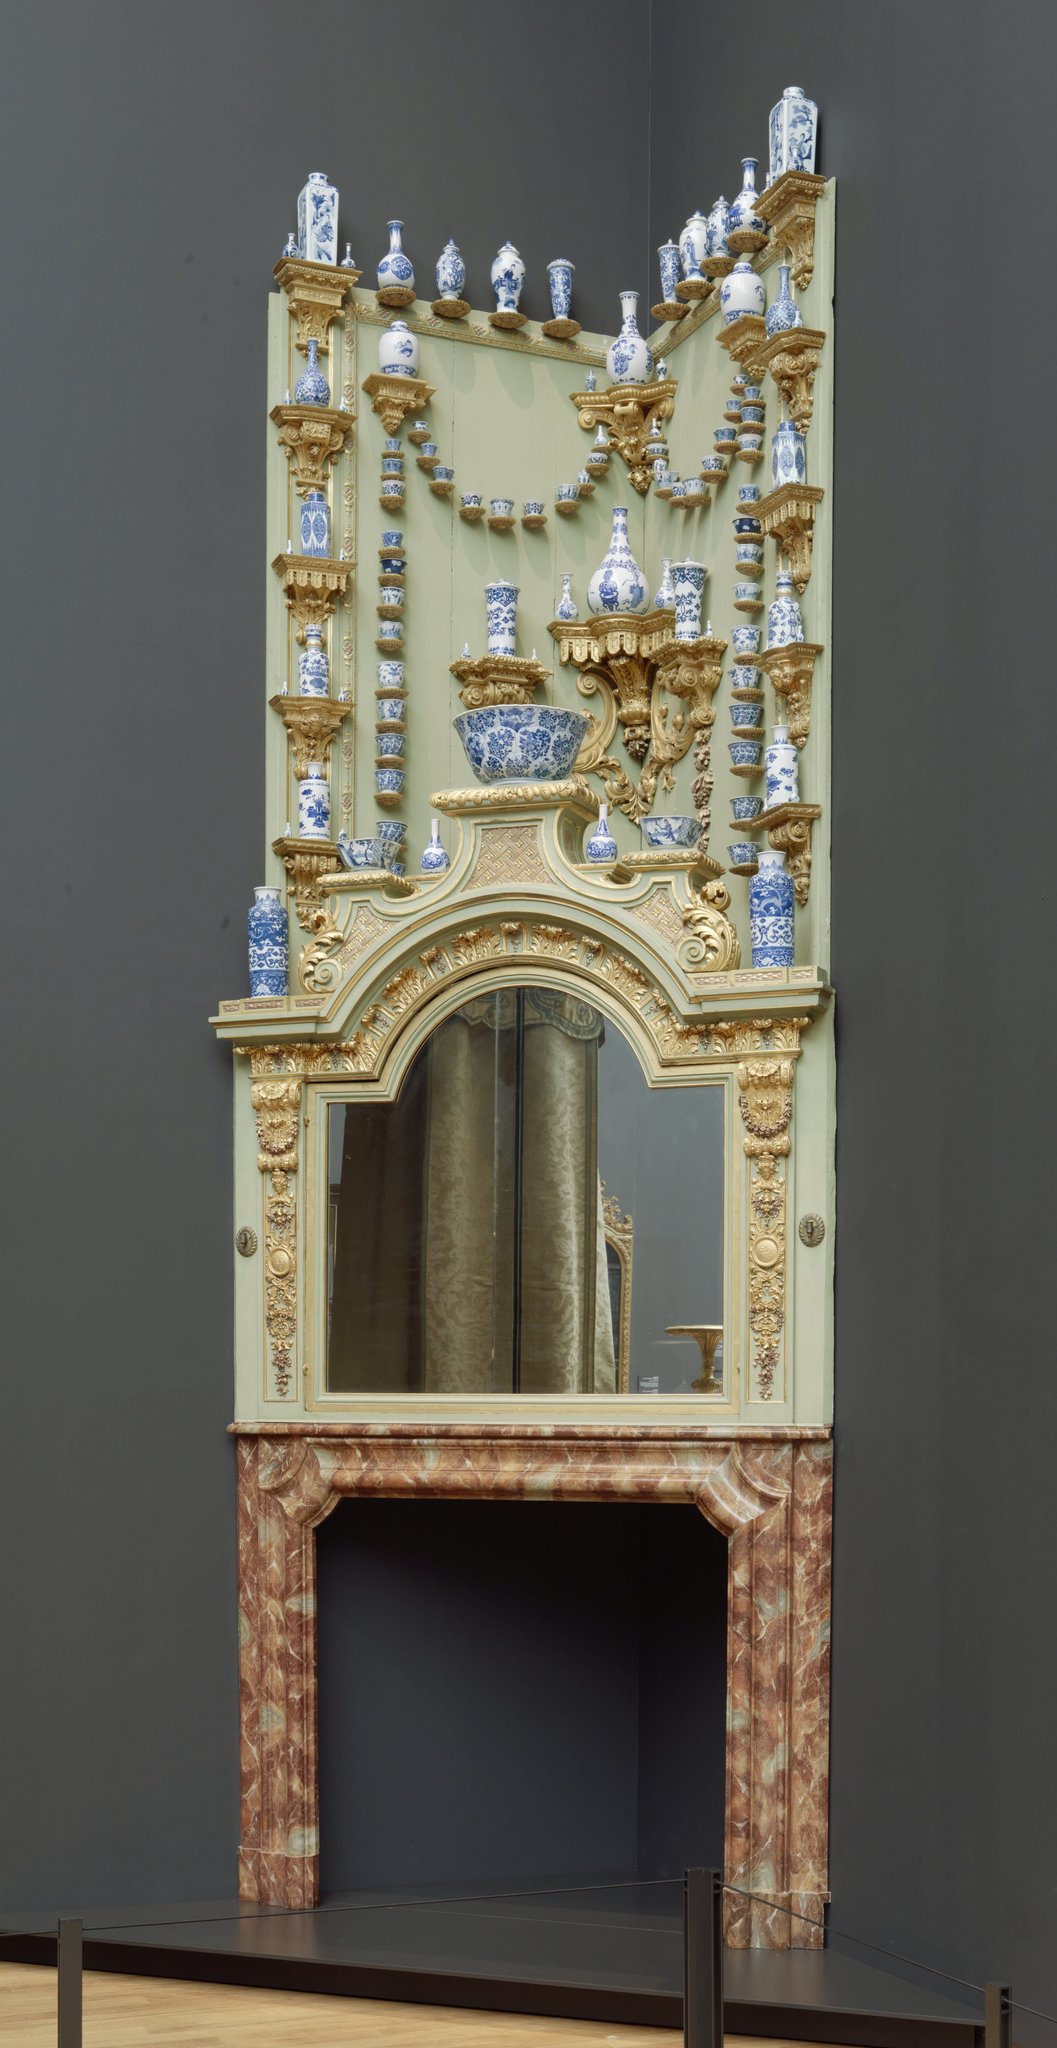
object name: interieuronderdeel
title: Corner chimneypiece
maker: Anonymous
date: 1700-1705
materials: copper, glass, marble, paint, wood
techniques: gilding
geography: the hague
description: This corner chimneypiece probably came from the house of one of William III’s courtiers on the Korte Voorhout in The Hague. Chinese porcelain abounds on all of the consoles. Daniël Marot recorded this manner of installation in a number of his prints. The marblized wooden surround of the stokehole comes from another chimneypiece.